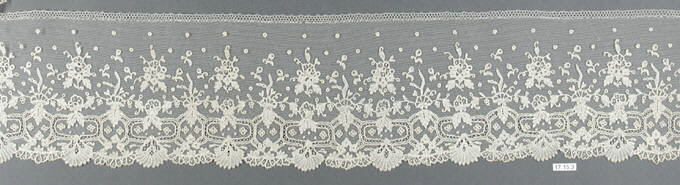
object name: border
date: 1860